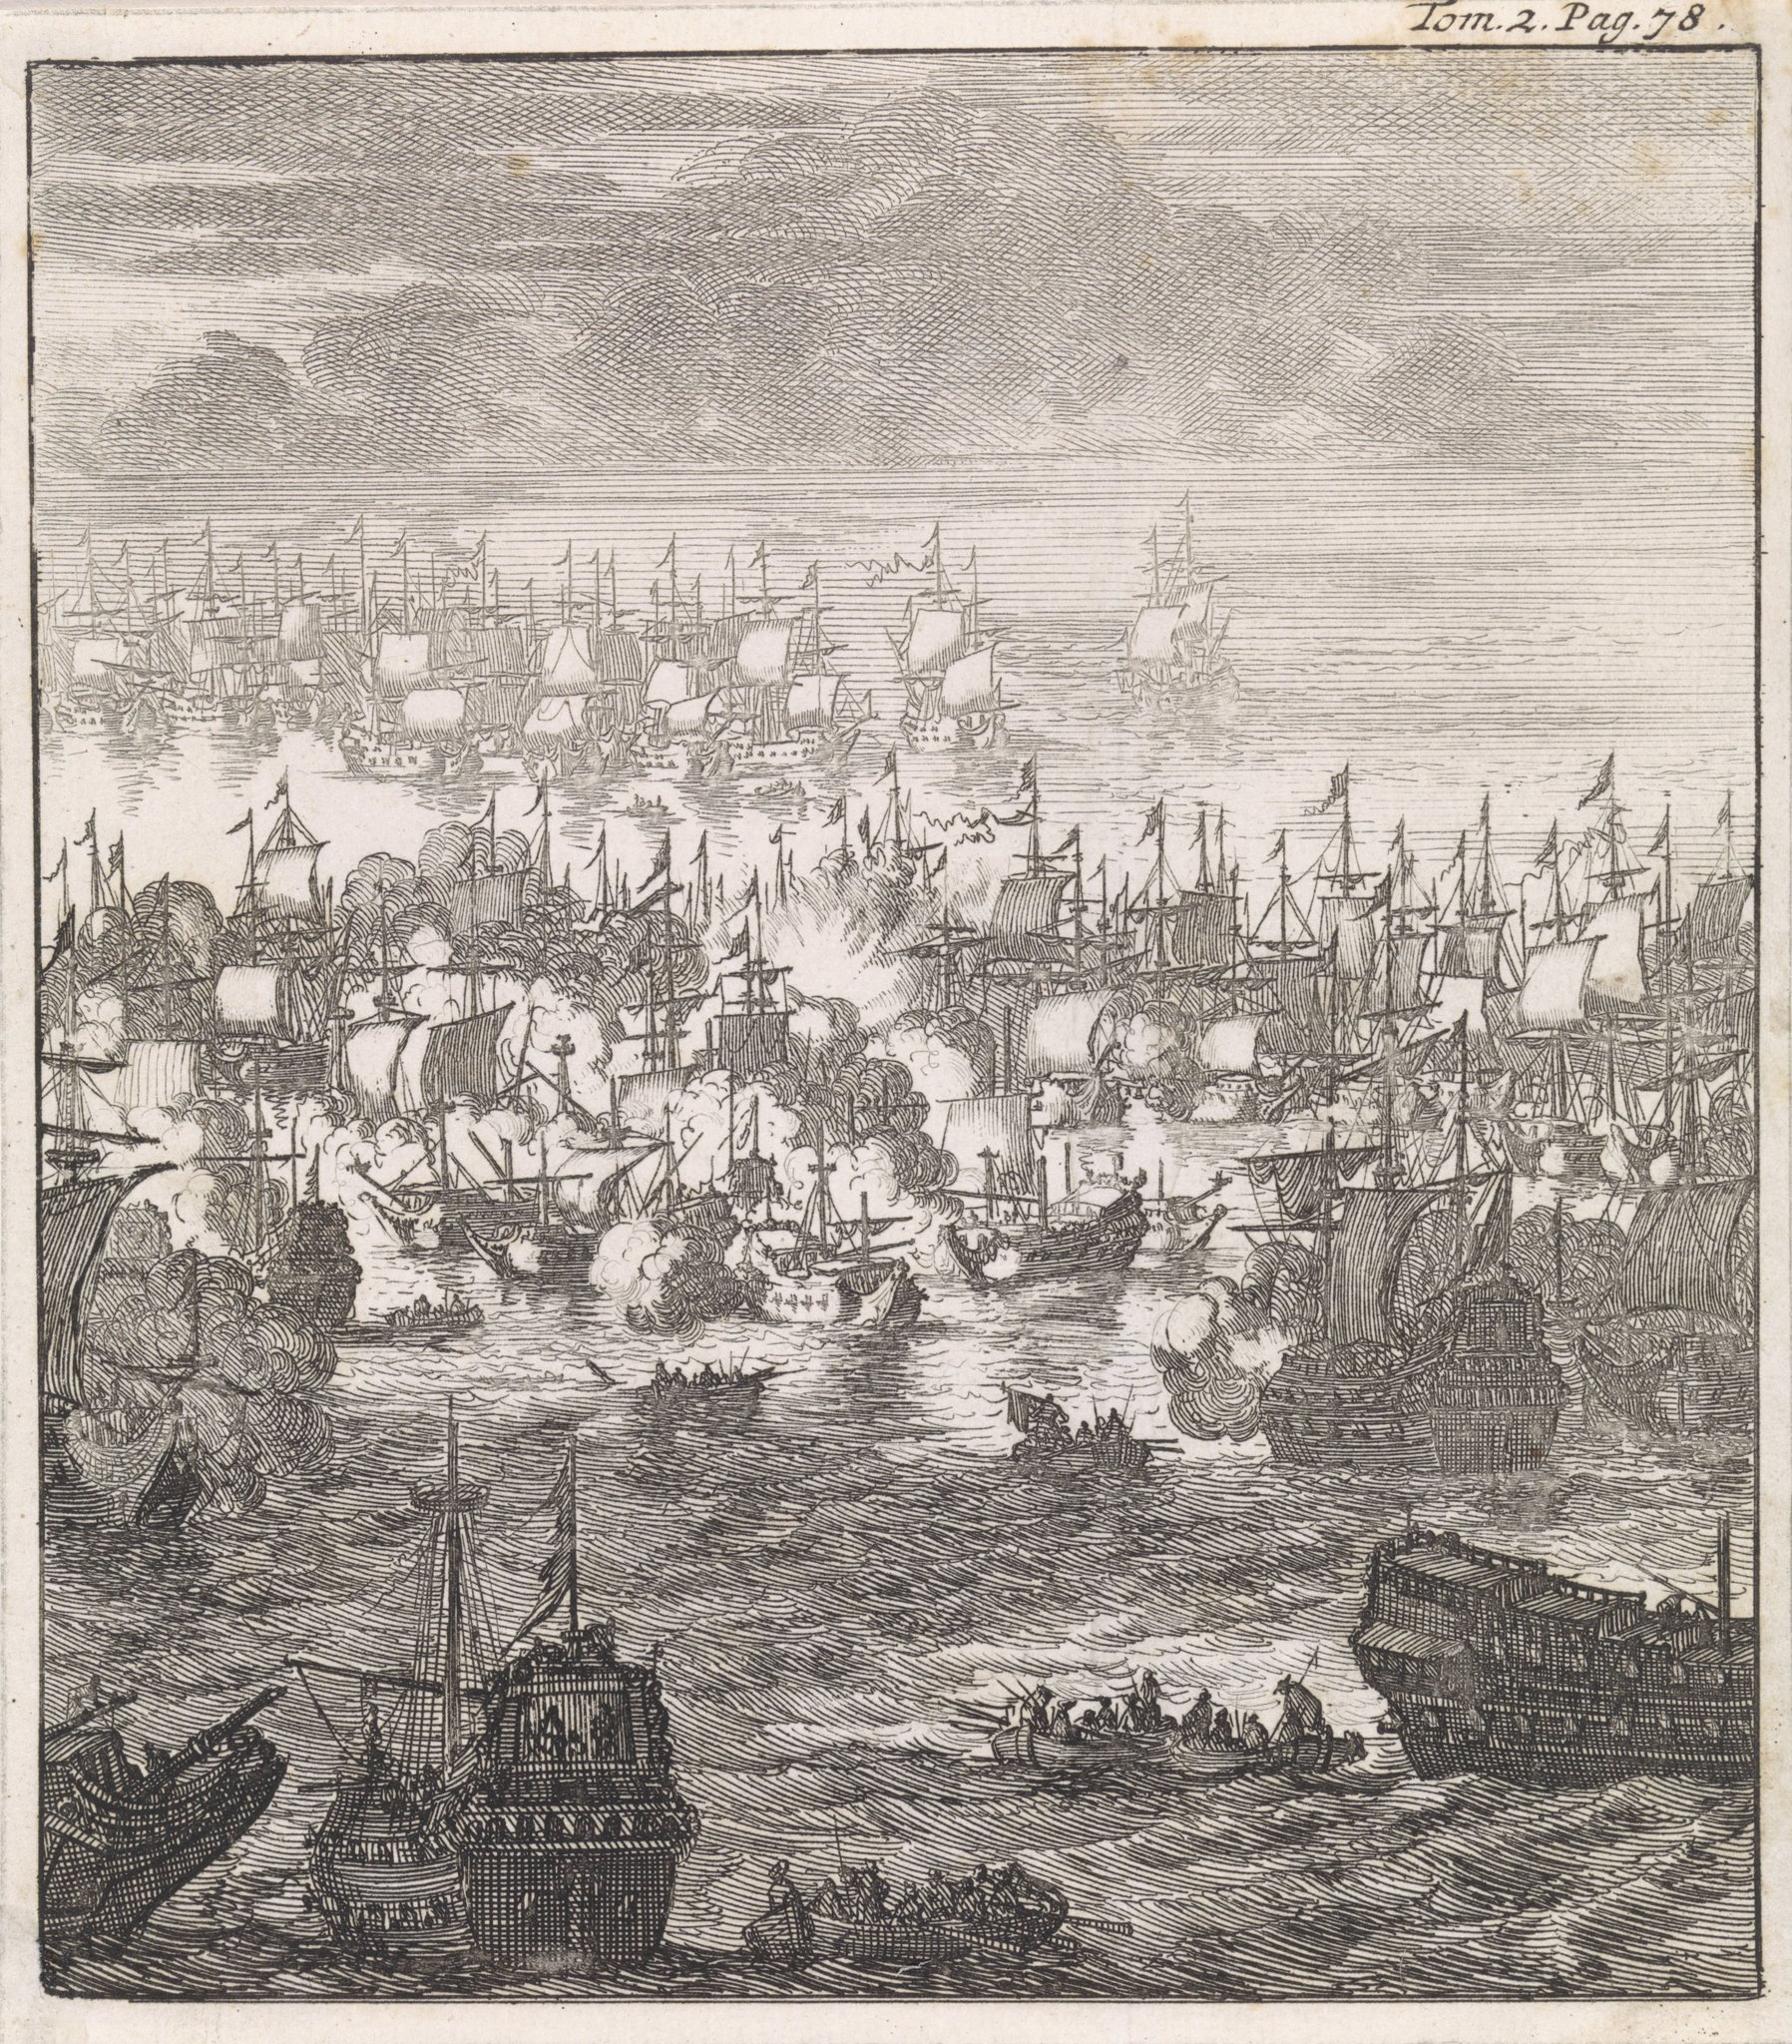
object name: book illustration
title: Zeeslag bij Beachy Head, 1690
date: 1703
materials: paper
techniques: etching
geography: amsterdam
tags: battle (+ naval force), battle of beachy head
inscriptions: collector's mark: Lugt 2228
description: Illustratie uit: Histoire de Guillaume III. roi d'Angleterre (...) prince d'Orange, 3 delen. Amsterdam: Pieter Mortier, 1703, dl. II, p. 78.